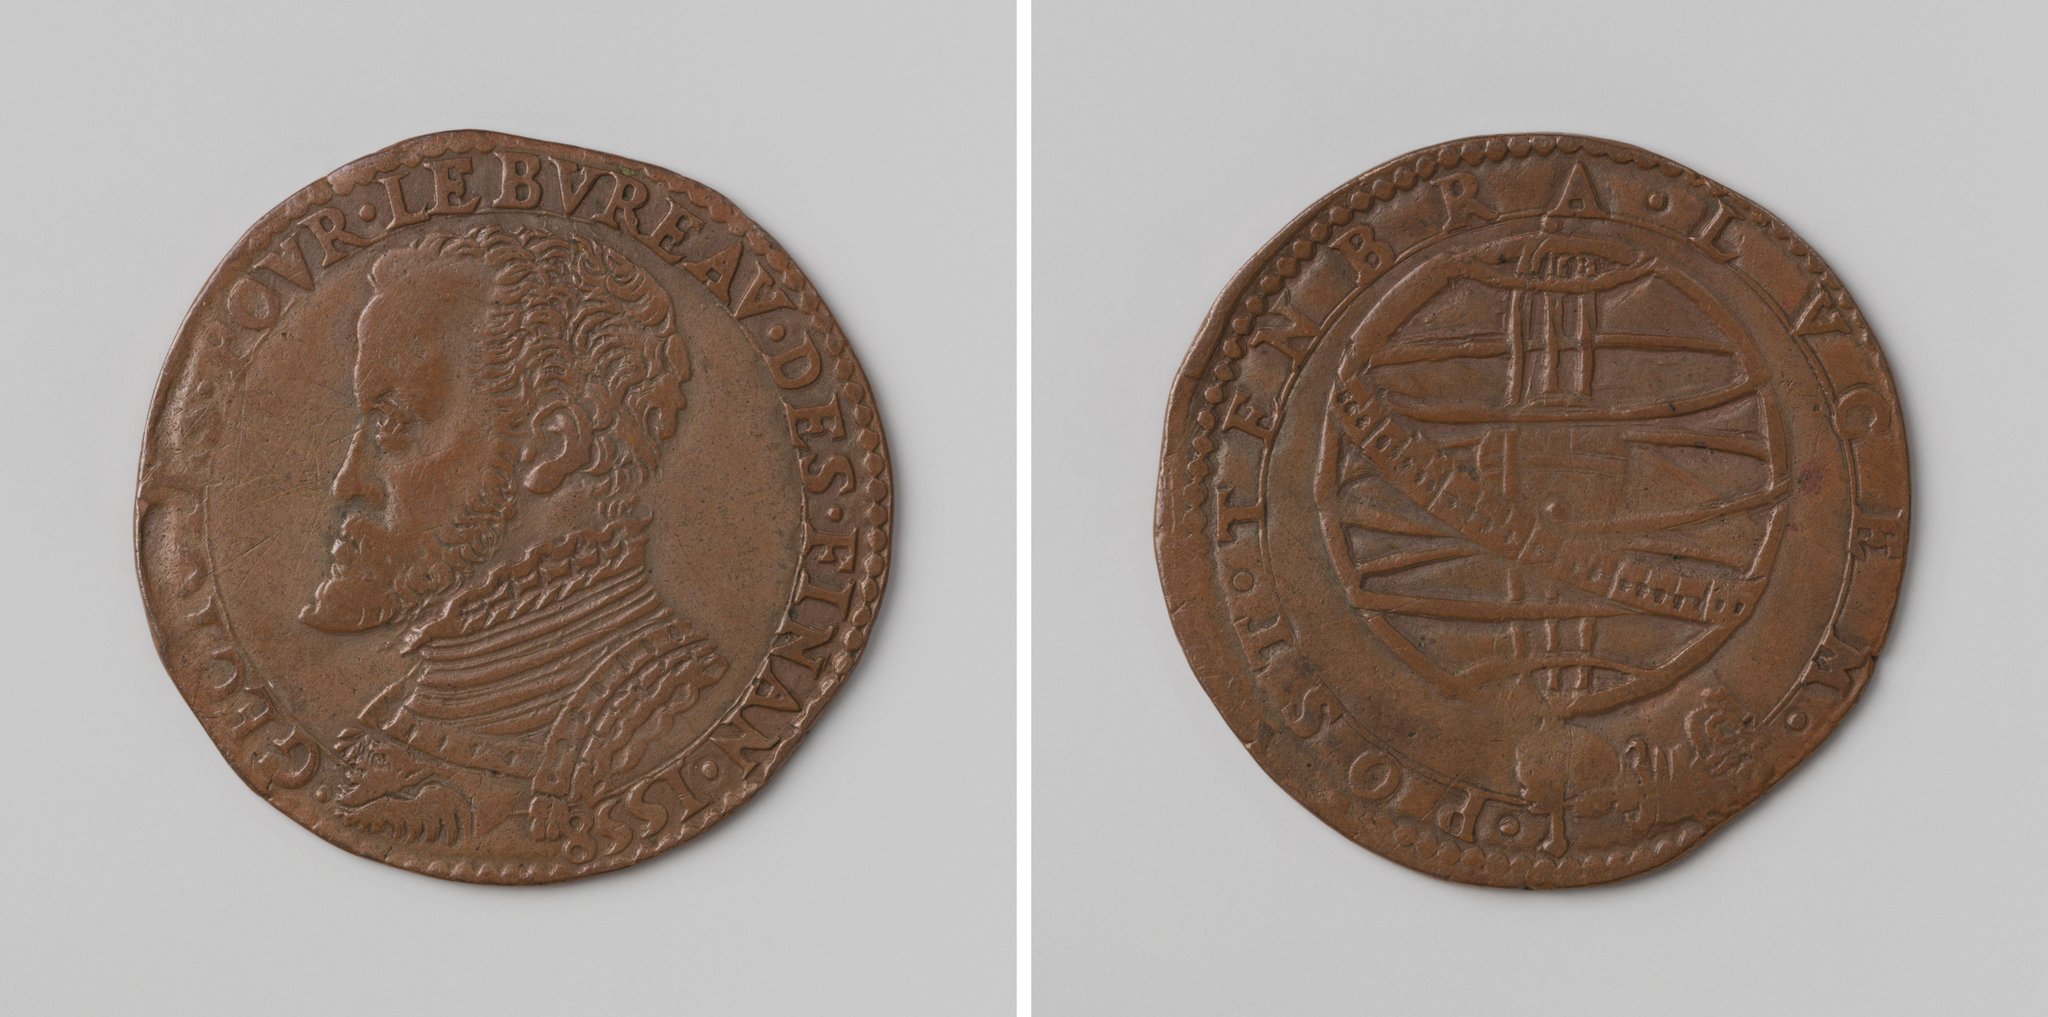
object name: jeton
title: Slag bij Grevelingen, ter ere van Filips II, koning van Spanje, rekenpenning van de raad van Financien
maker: Anonymous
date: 1558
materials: copper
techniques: striking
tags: philip ii of spain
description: Koperen penning. Voorzijde: borststuk man binnen omschrift. Keerzijde: aardbol, omgeven door hemelsferen, vastgehouden door hand binnen omschrift